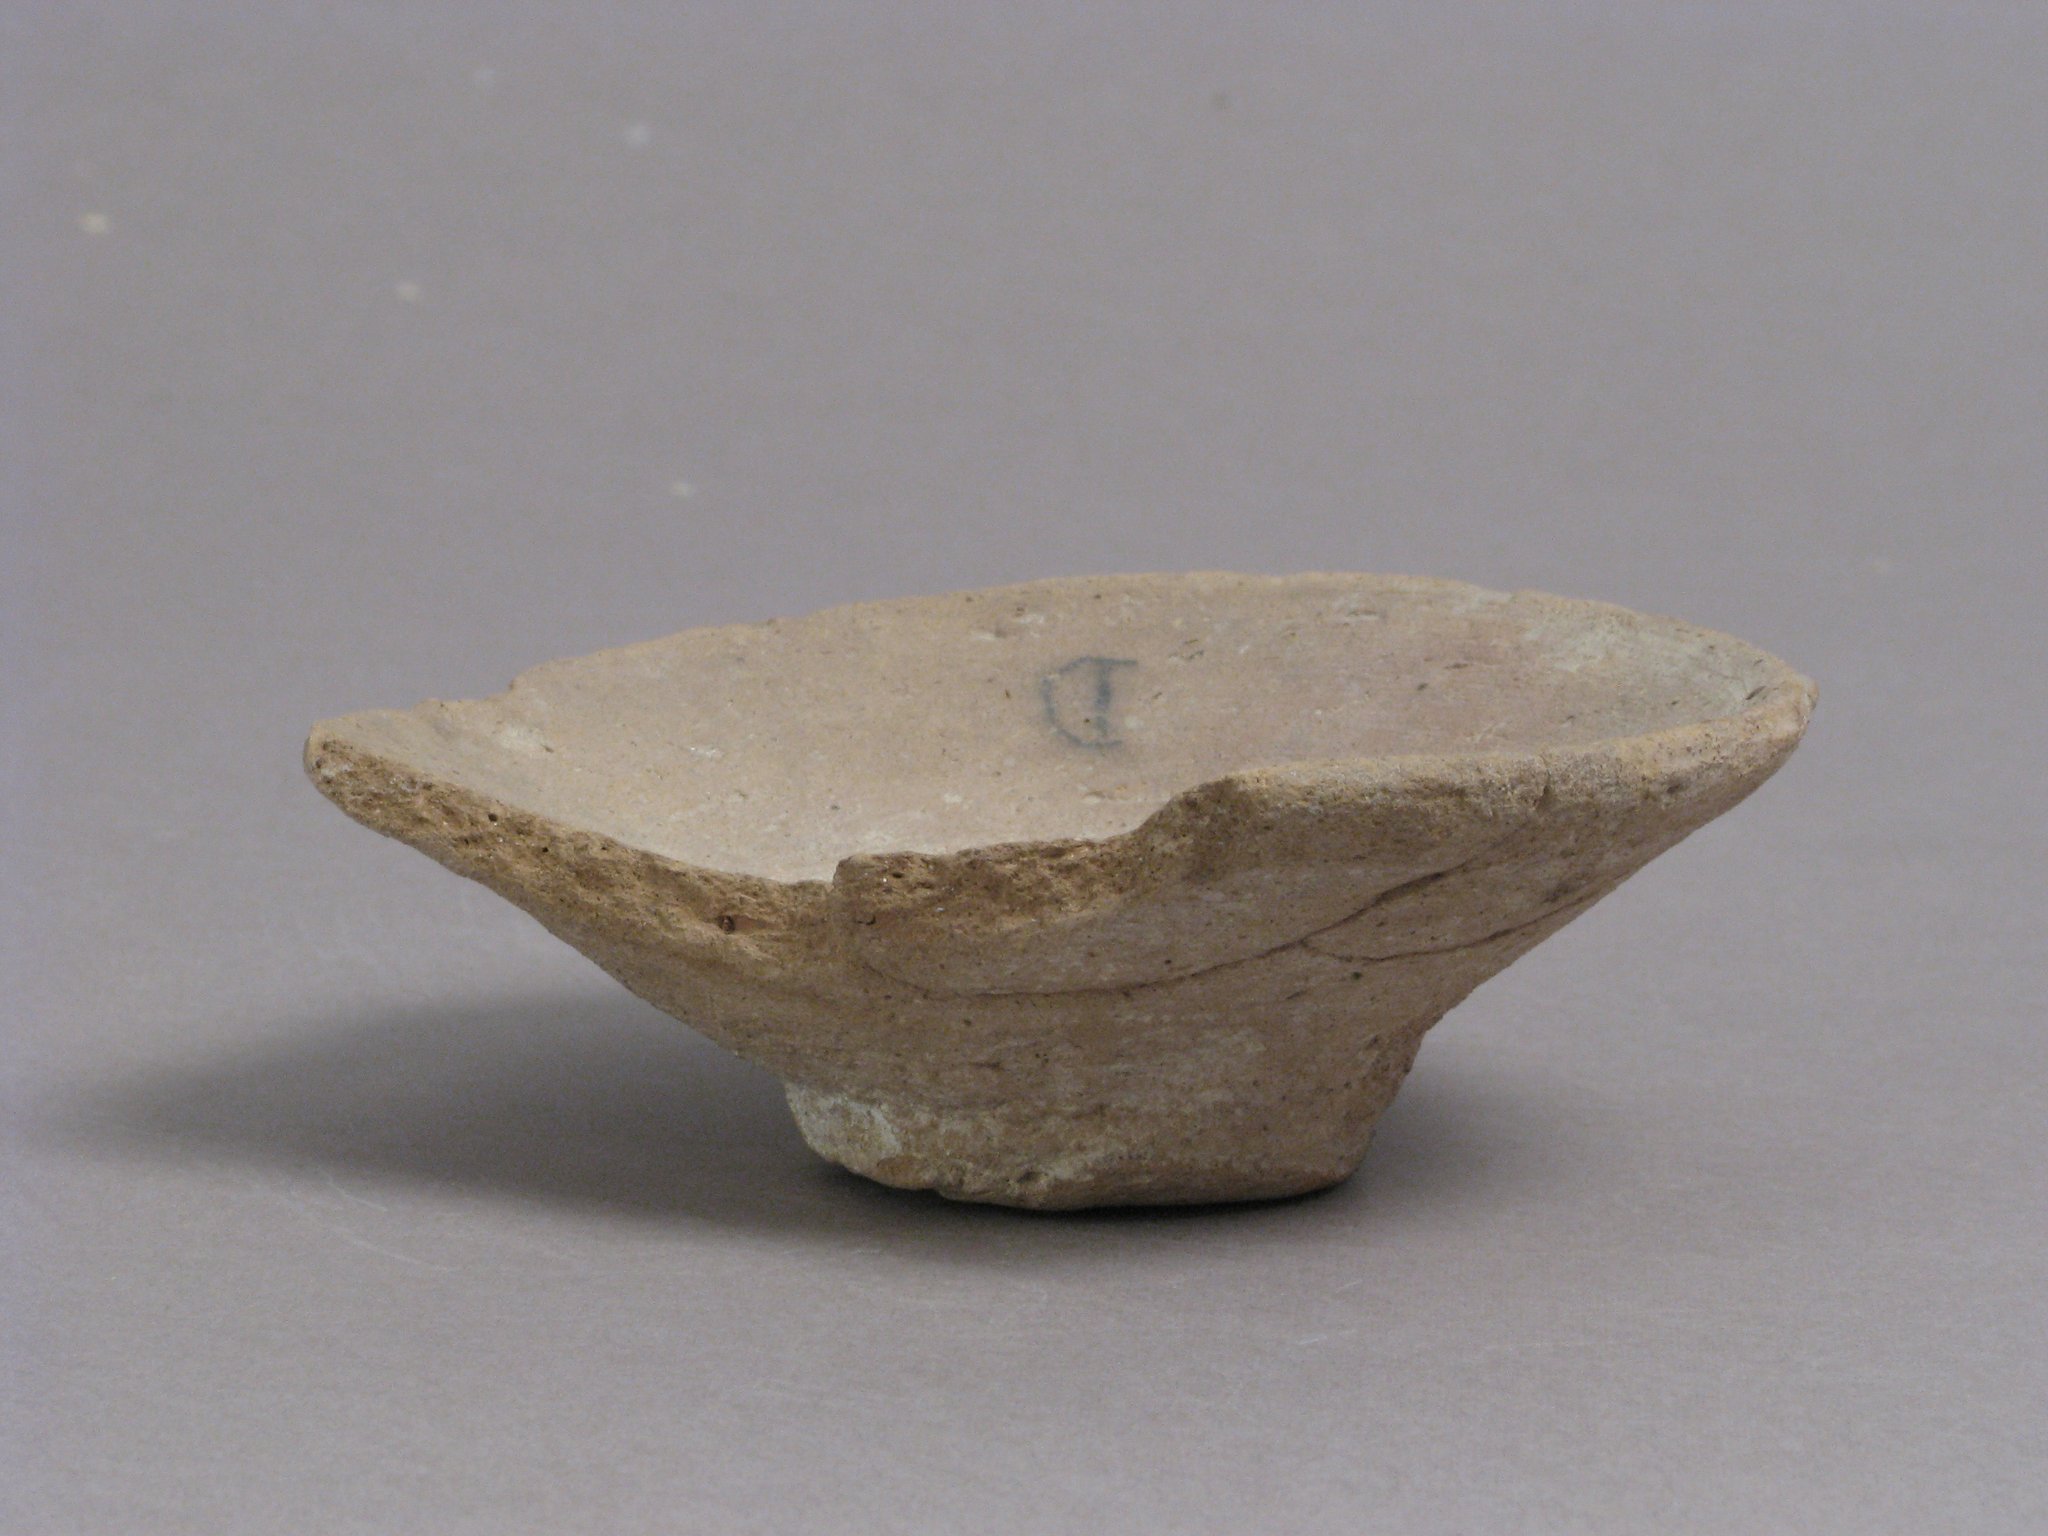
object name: bowl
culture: coptic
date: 301-700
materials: earthenware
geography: egypt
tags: bowls